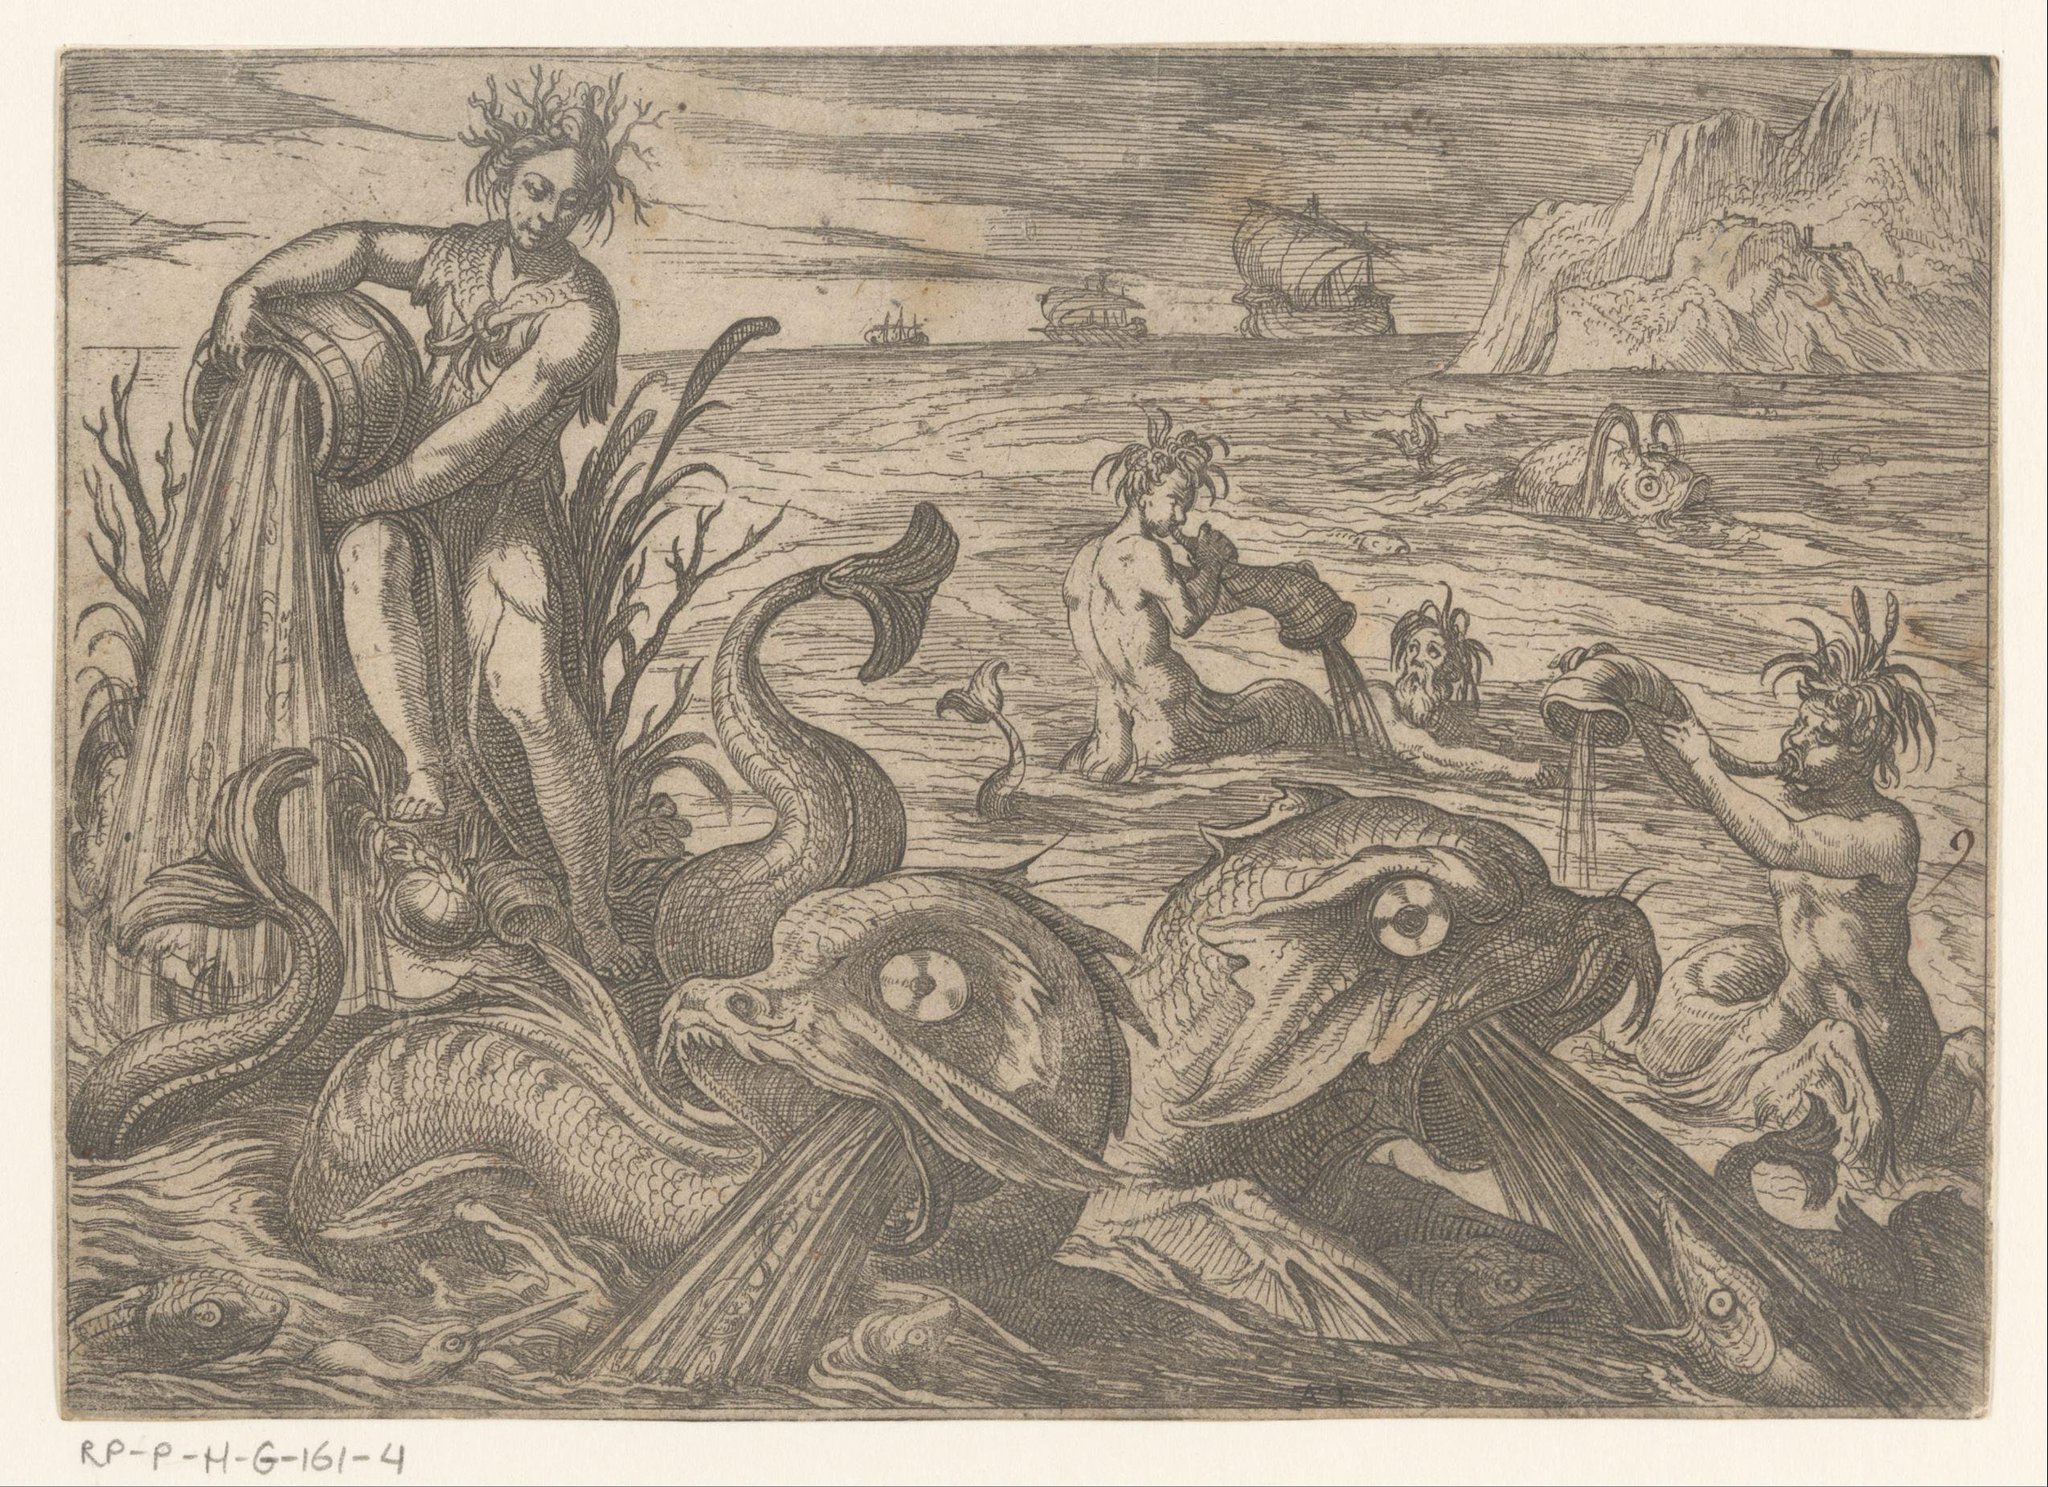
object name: print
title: Water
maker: antonio tempesta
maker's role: draughtsman, painter, print maker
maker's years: 1555-1630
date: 1565-1630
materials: paper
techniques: etching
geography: italy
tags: triton(s), water (one of the four elements), fishes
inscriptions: collector's mark: ‘Hinloopen’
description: Zeelandschap met de vrouwelijke personificatie van water met een grote kruik waaruit zij water giet. In het water zwemmen tritons, grote zeemonsters en vissen. Op de achtergrond varen schepen op zee.